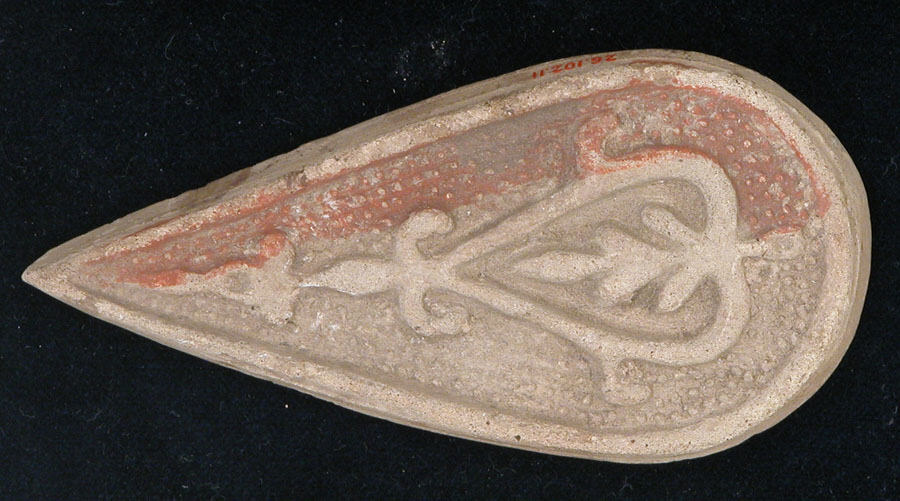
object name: bath scraper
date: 1101-1300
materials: earthenware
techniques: molding, painting, relief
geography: iran